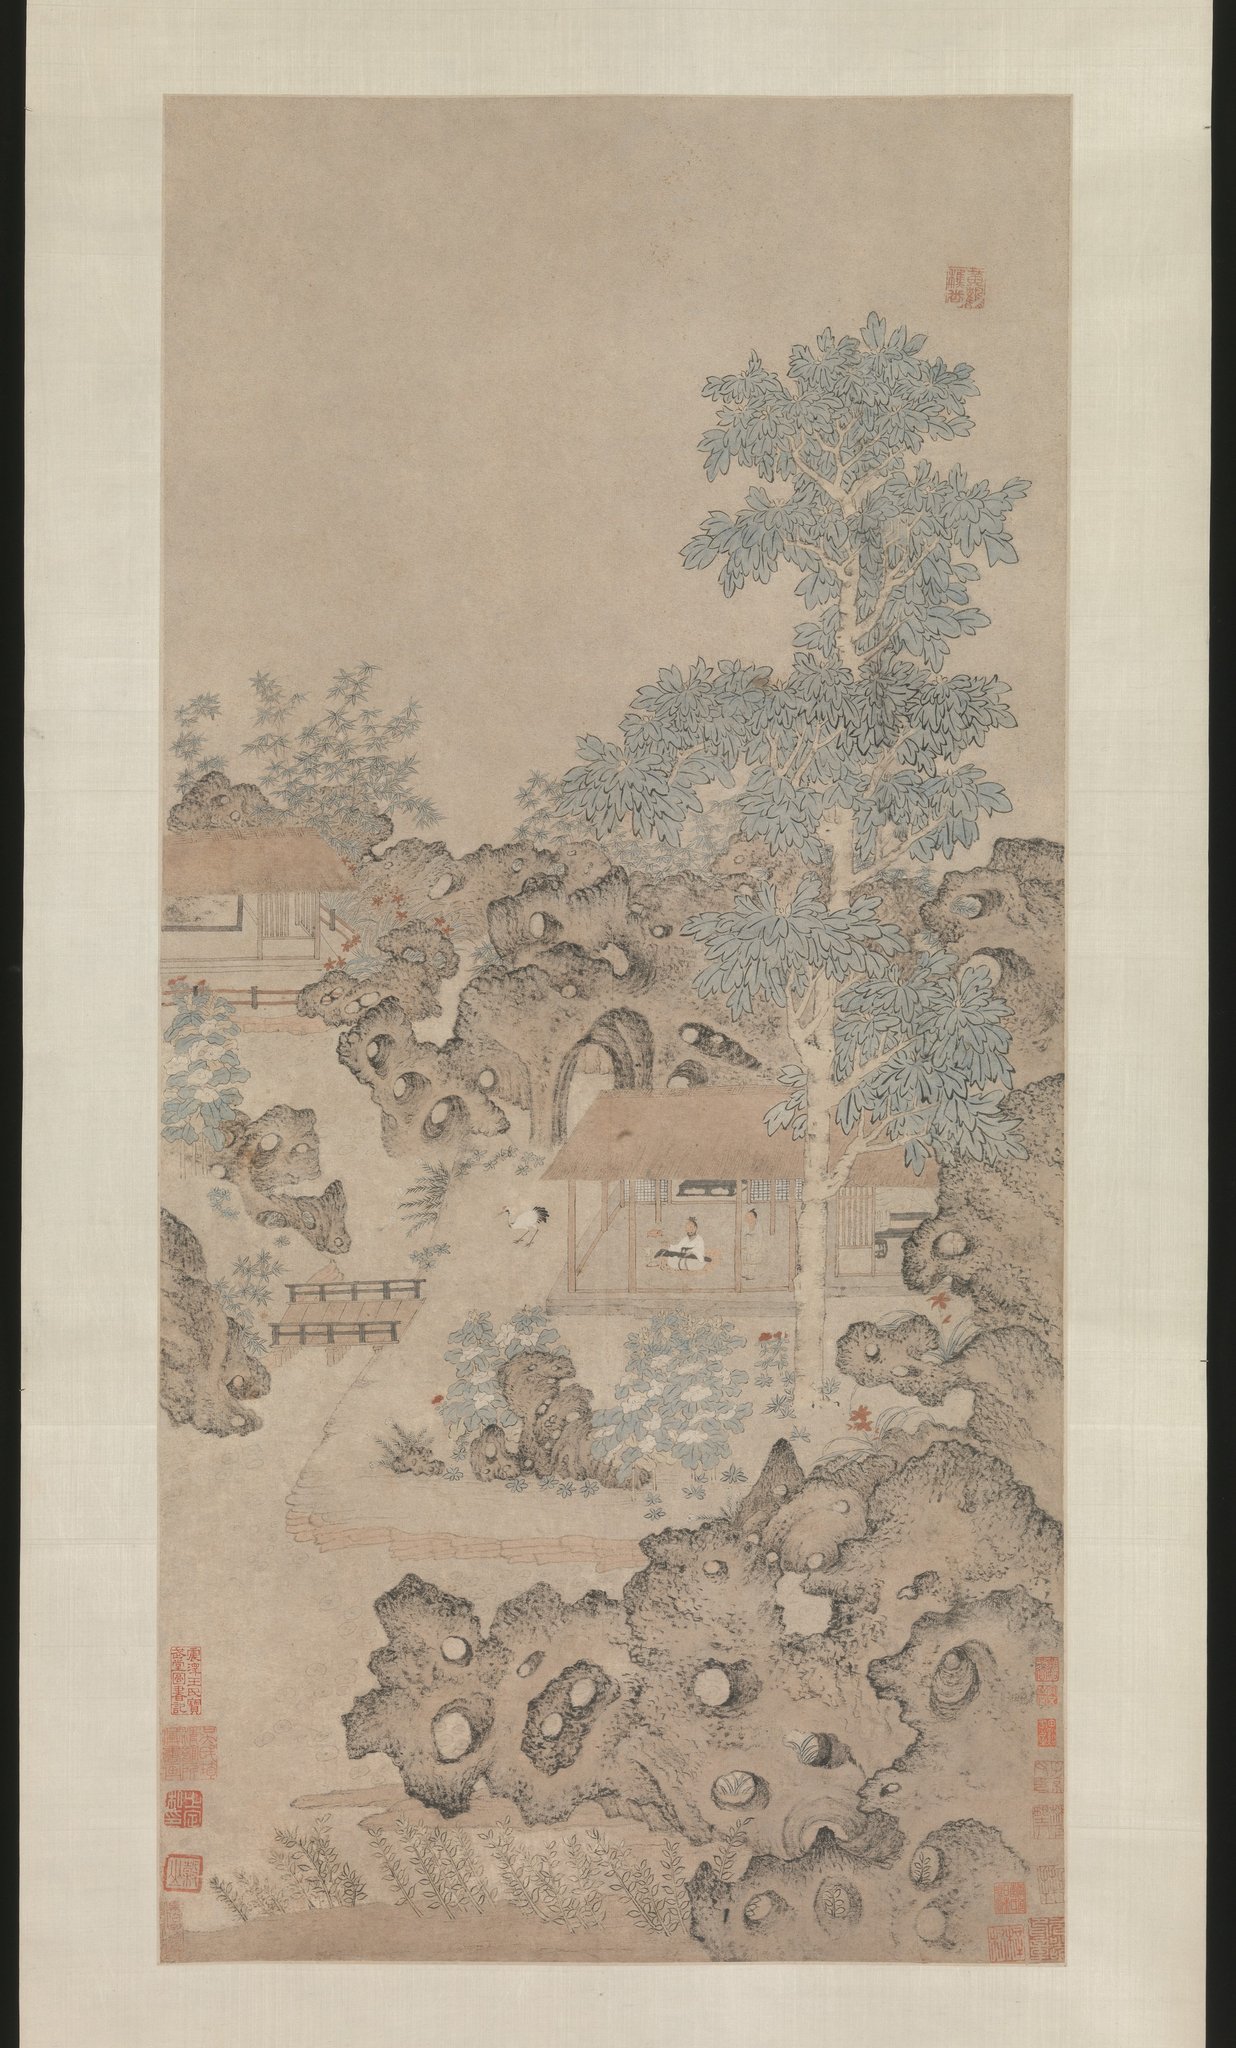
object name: hanging scroll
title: Playing the zither for a crane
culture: chinese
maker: unidentified artist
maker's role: artist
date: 1501-1600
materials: ink, paper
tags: musical instruments,cranes,men,landscapes